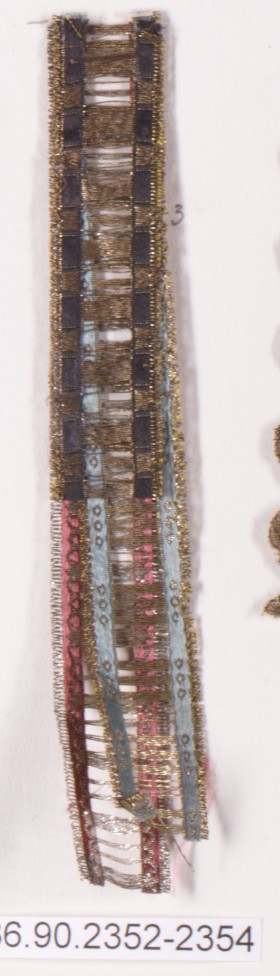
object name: ribbon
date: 1801-1900